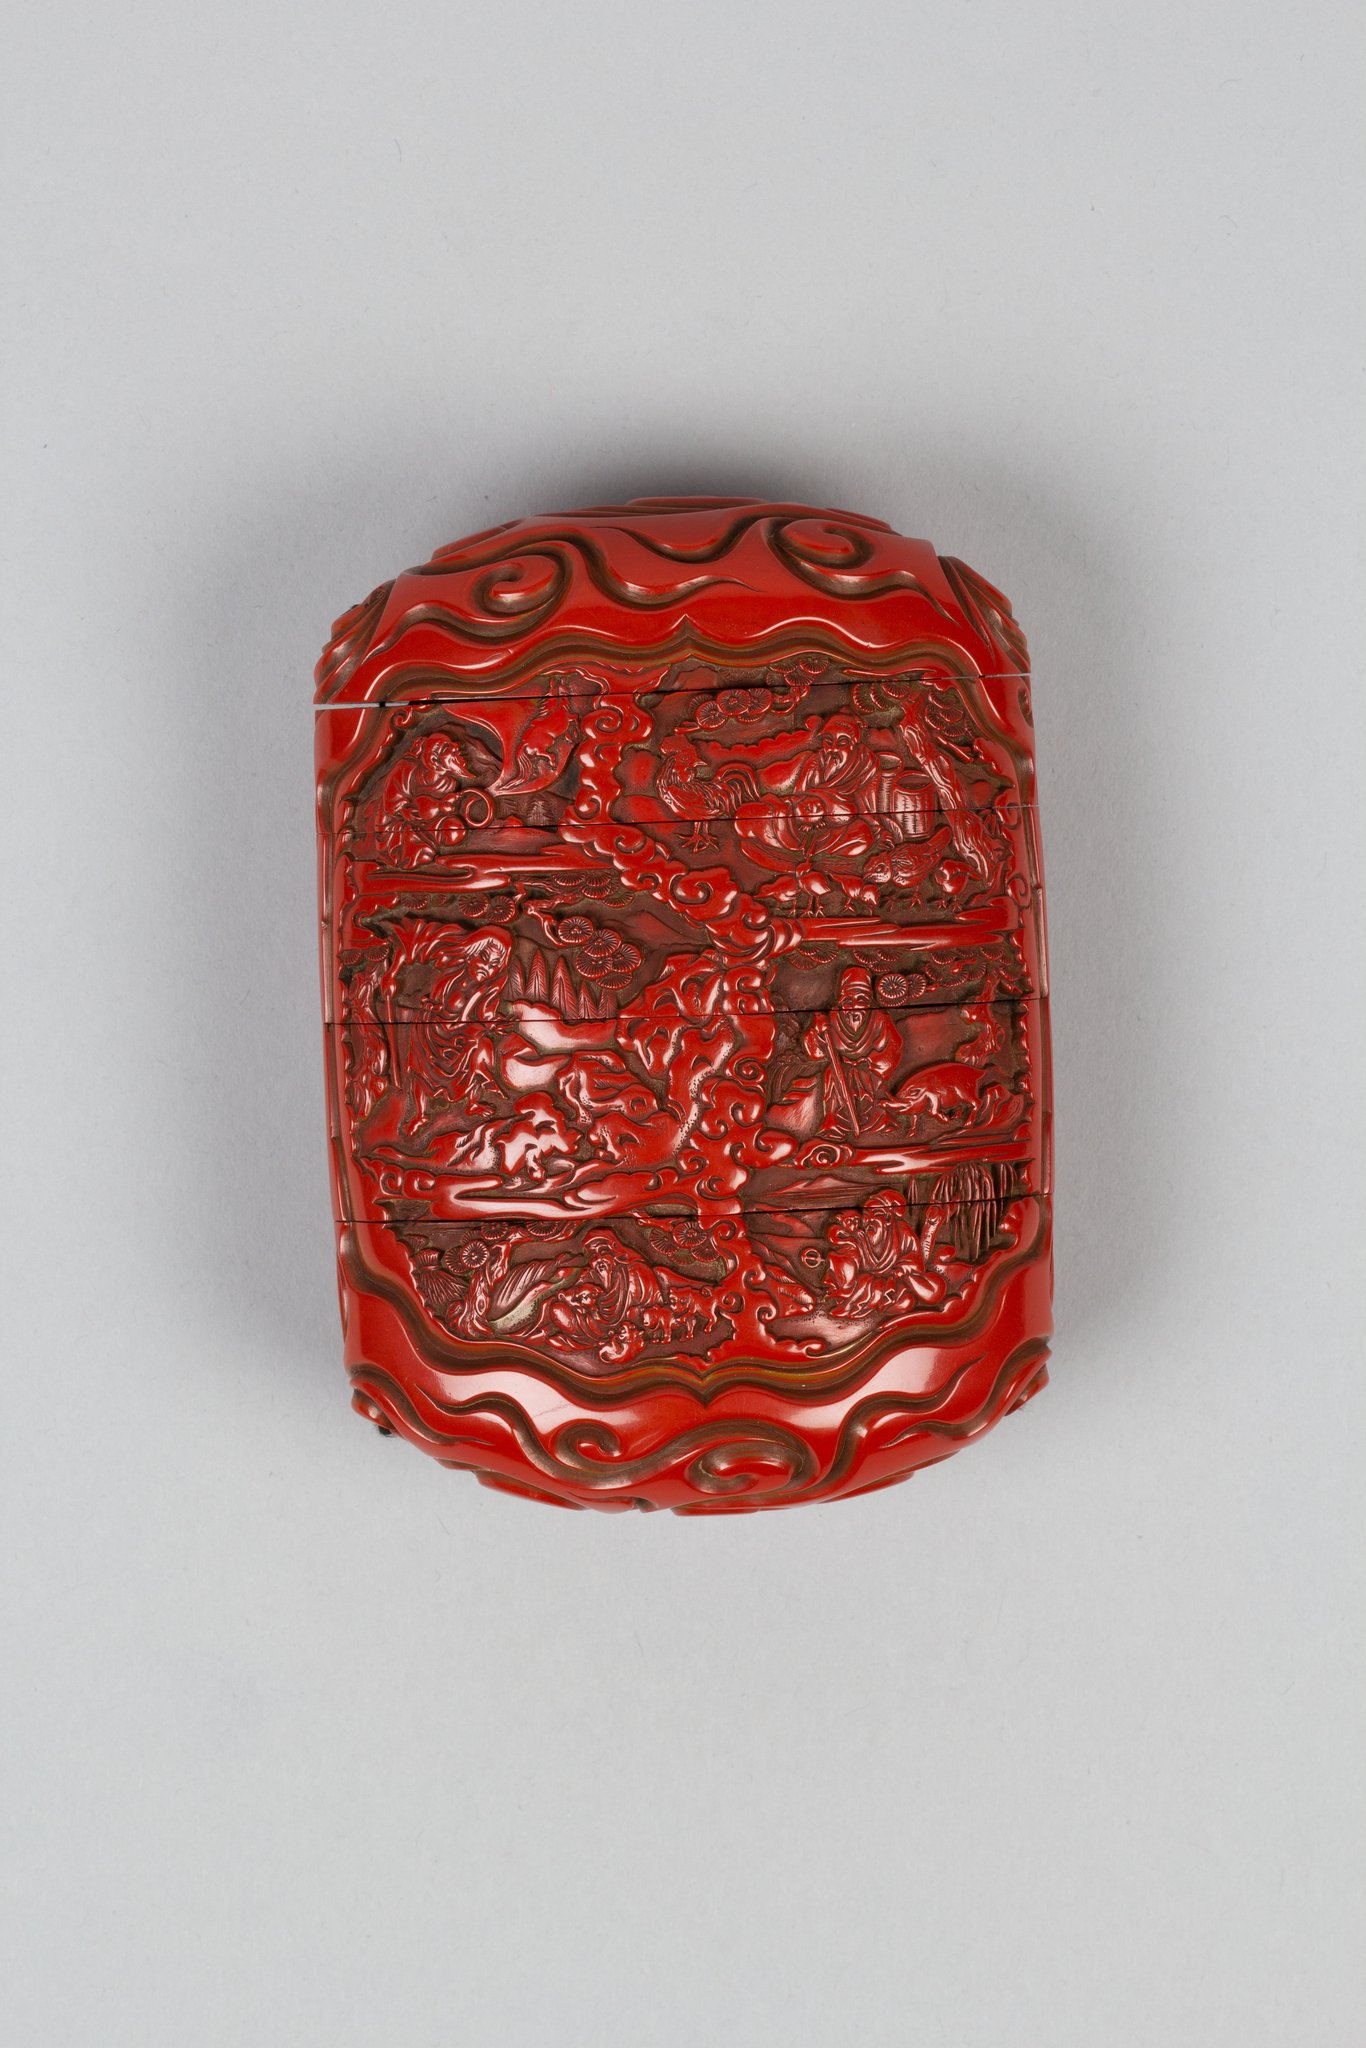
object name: inrō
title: Case (Inrō) with Design of Zodiac Animals beside Chinese Sages and Scrolls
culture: japanese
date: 1615-1868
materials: lacquer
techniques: carving, roiro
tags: animals,men,zodiac